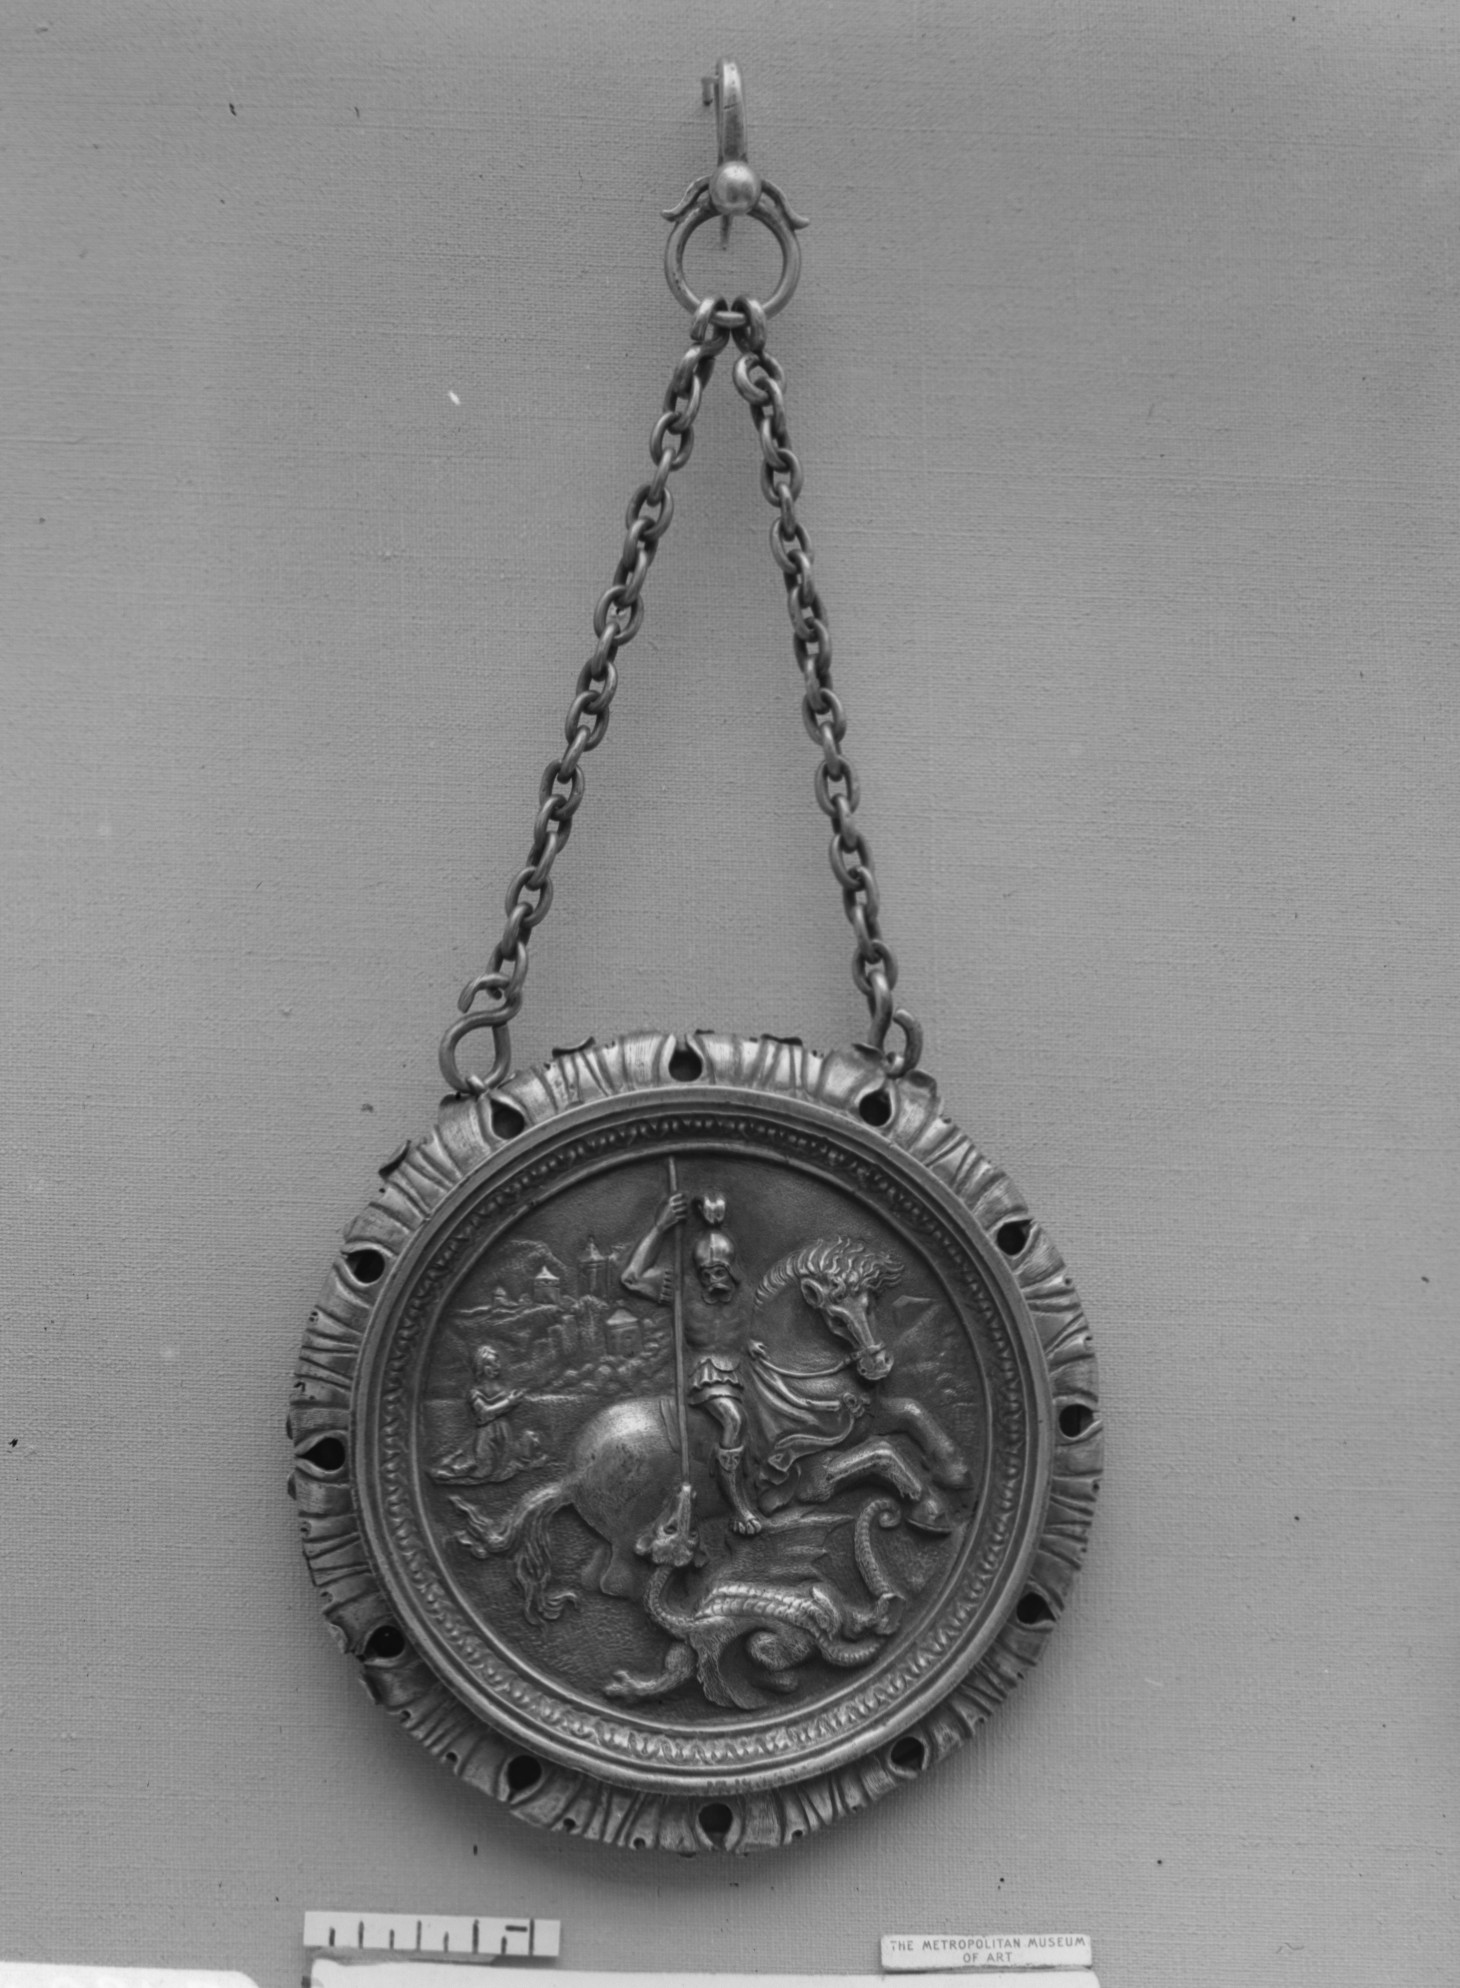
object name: medallion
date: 1501-1600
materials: silver gilt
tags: dragons,horses